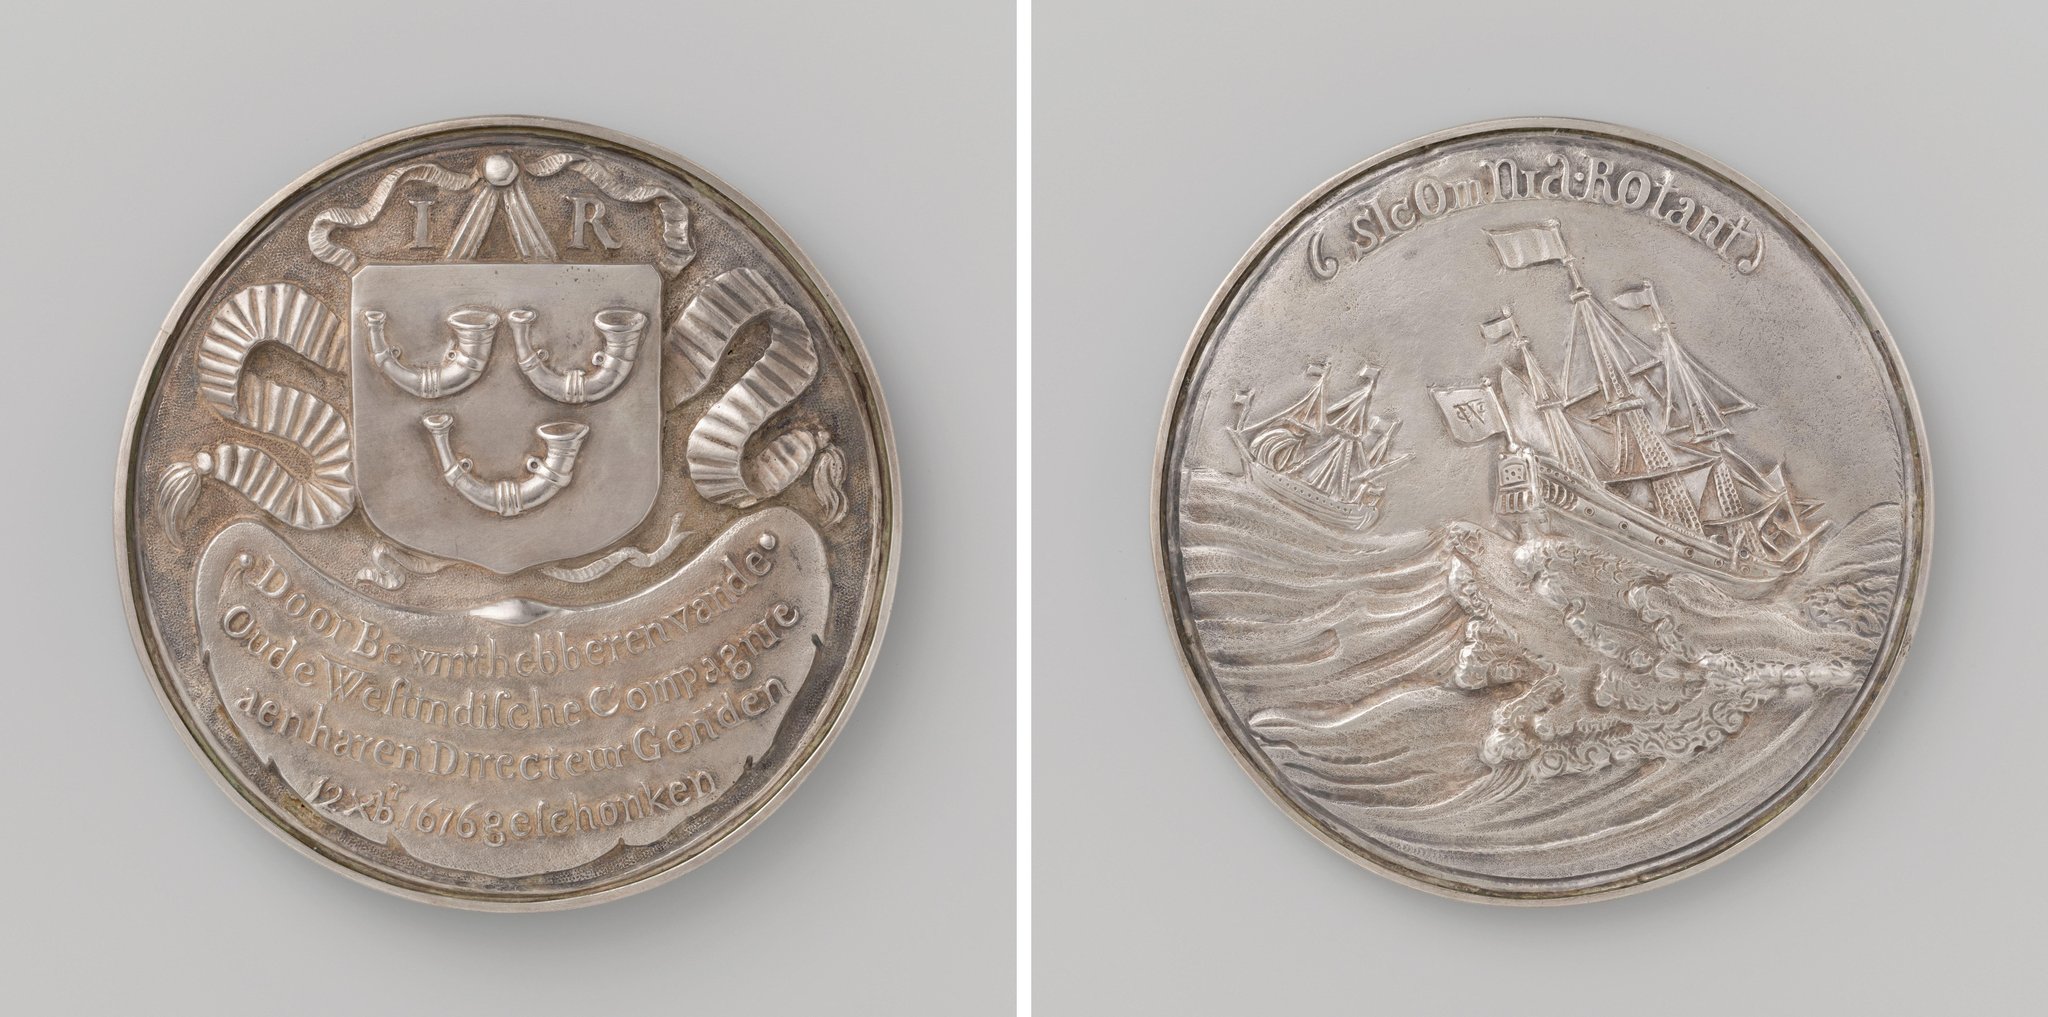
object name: copy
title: Oude Westindische Compagnie, penning door de bewindhebbers aan directeur-generaal J. Root, geschonken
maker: Anonymous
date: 1676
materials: metal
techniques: casting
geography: netherlands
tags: directeur-generaal, j. root, west-indische compagnie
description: Penning. Voorzijde: wapenschild met lint tussen monogram boven opschrift. Keerzijde: twee schepen van de WIC op zee binnen omschrift.